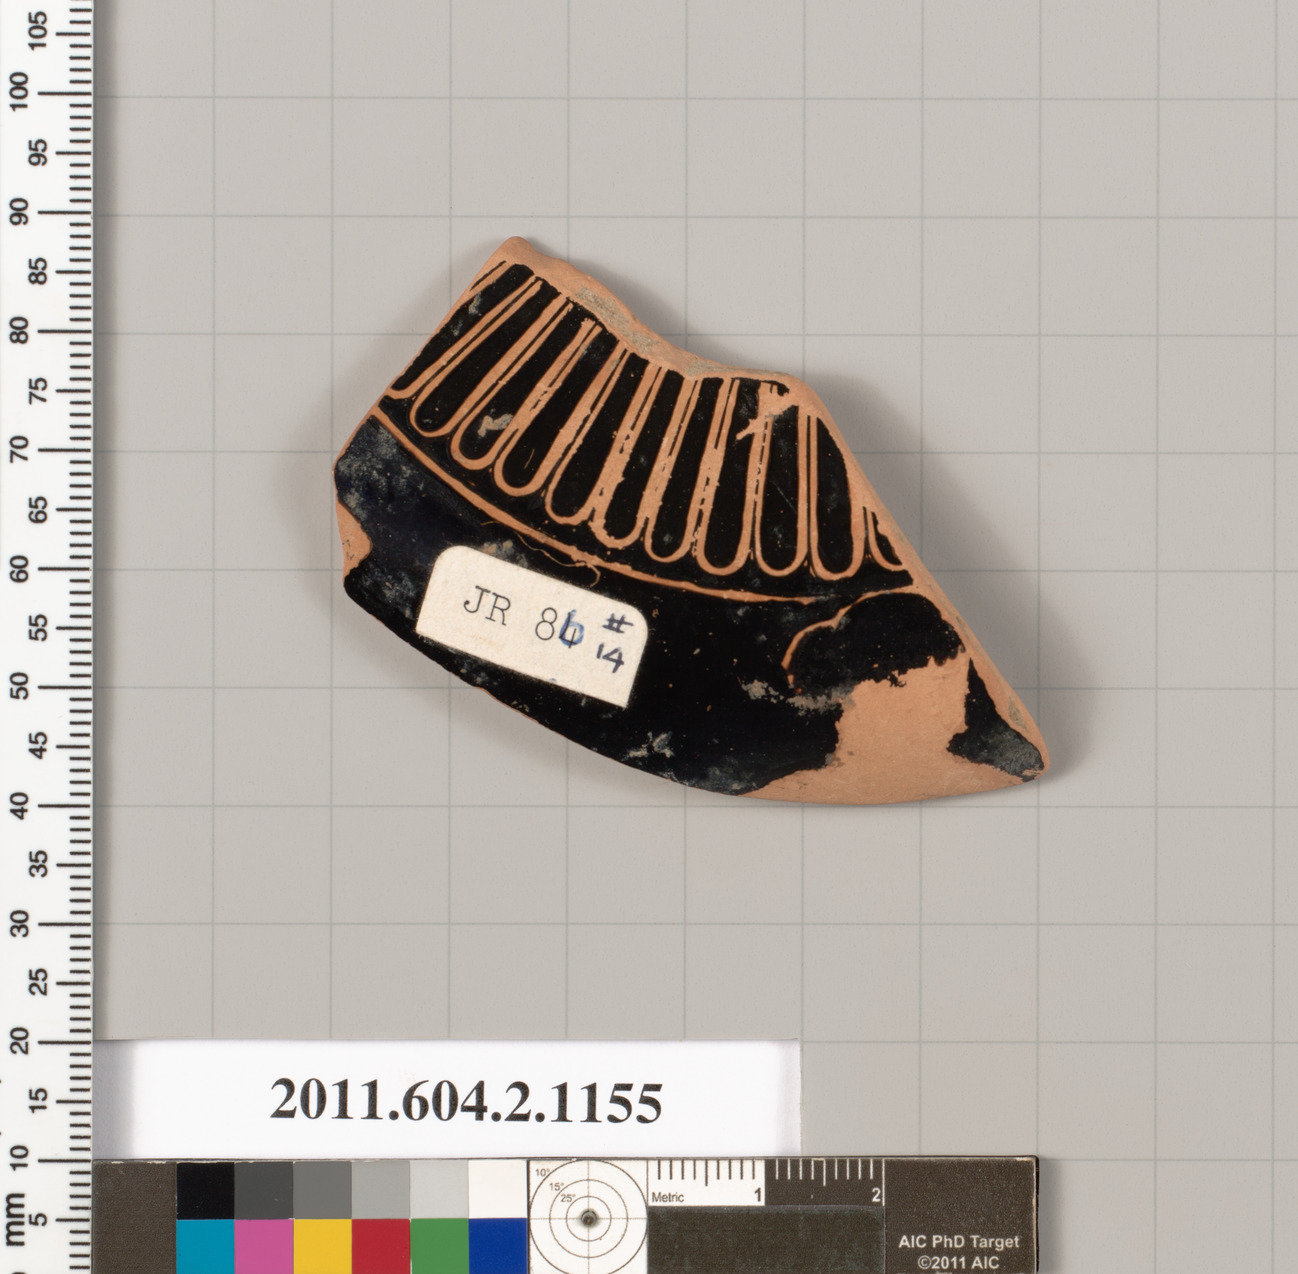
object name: oinochoe fragment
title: Terracotta fragment of an oinochoe (jug)?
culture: greek, attic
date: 460-450 BCE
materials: terracotta